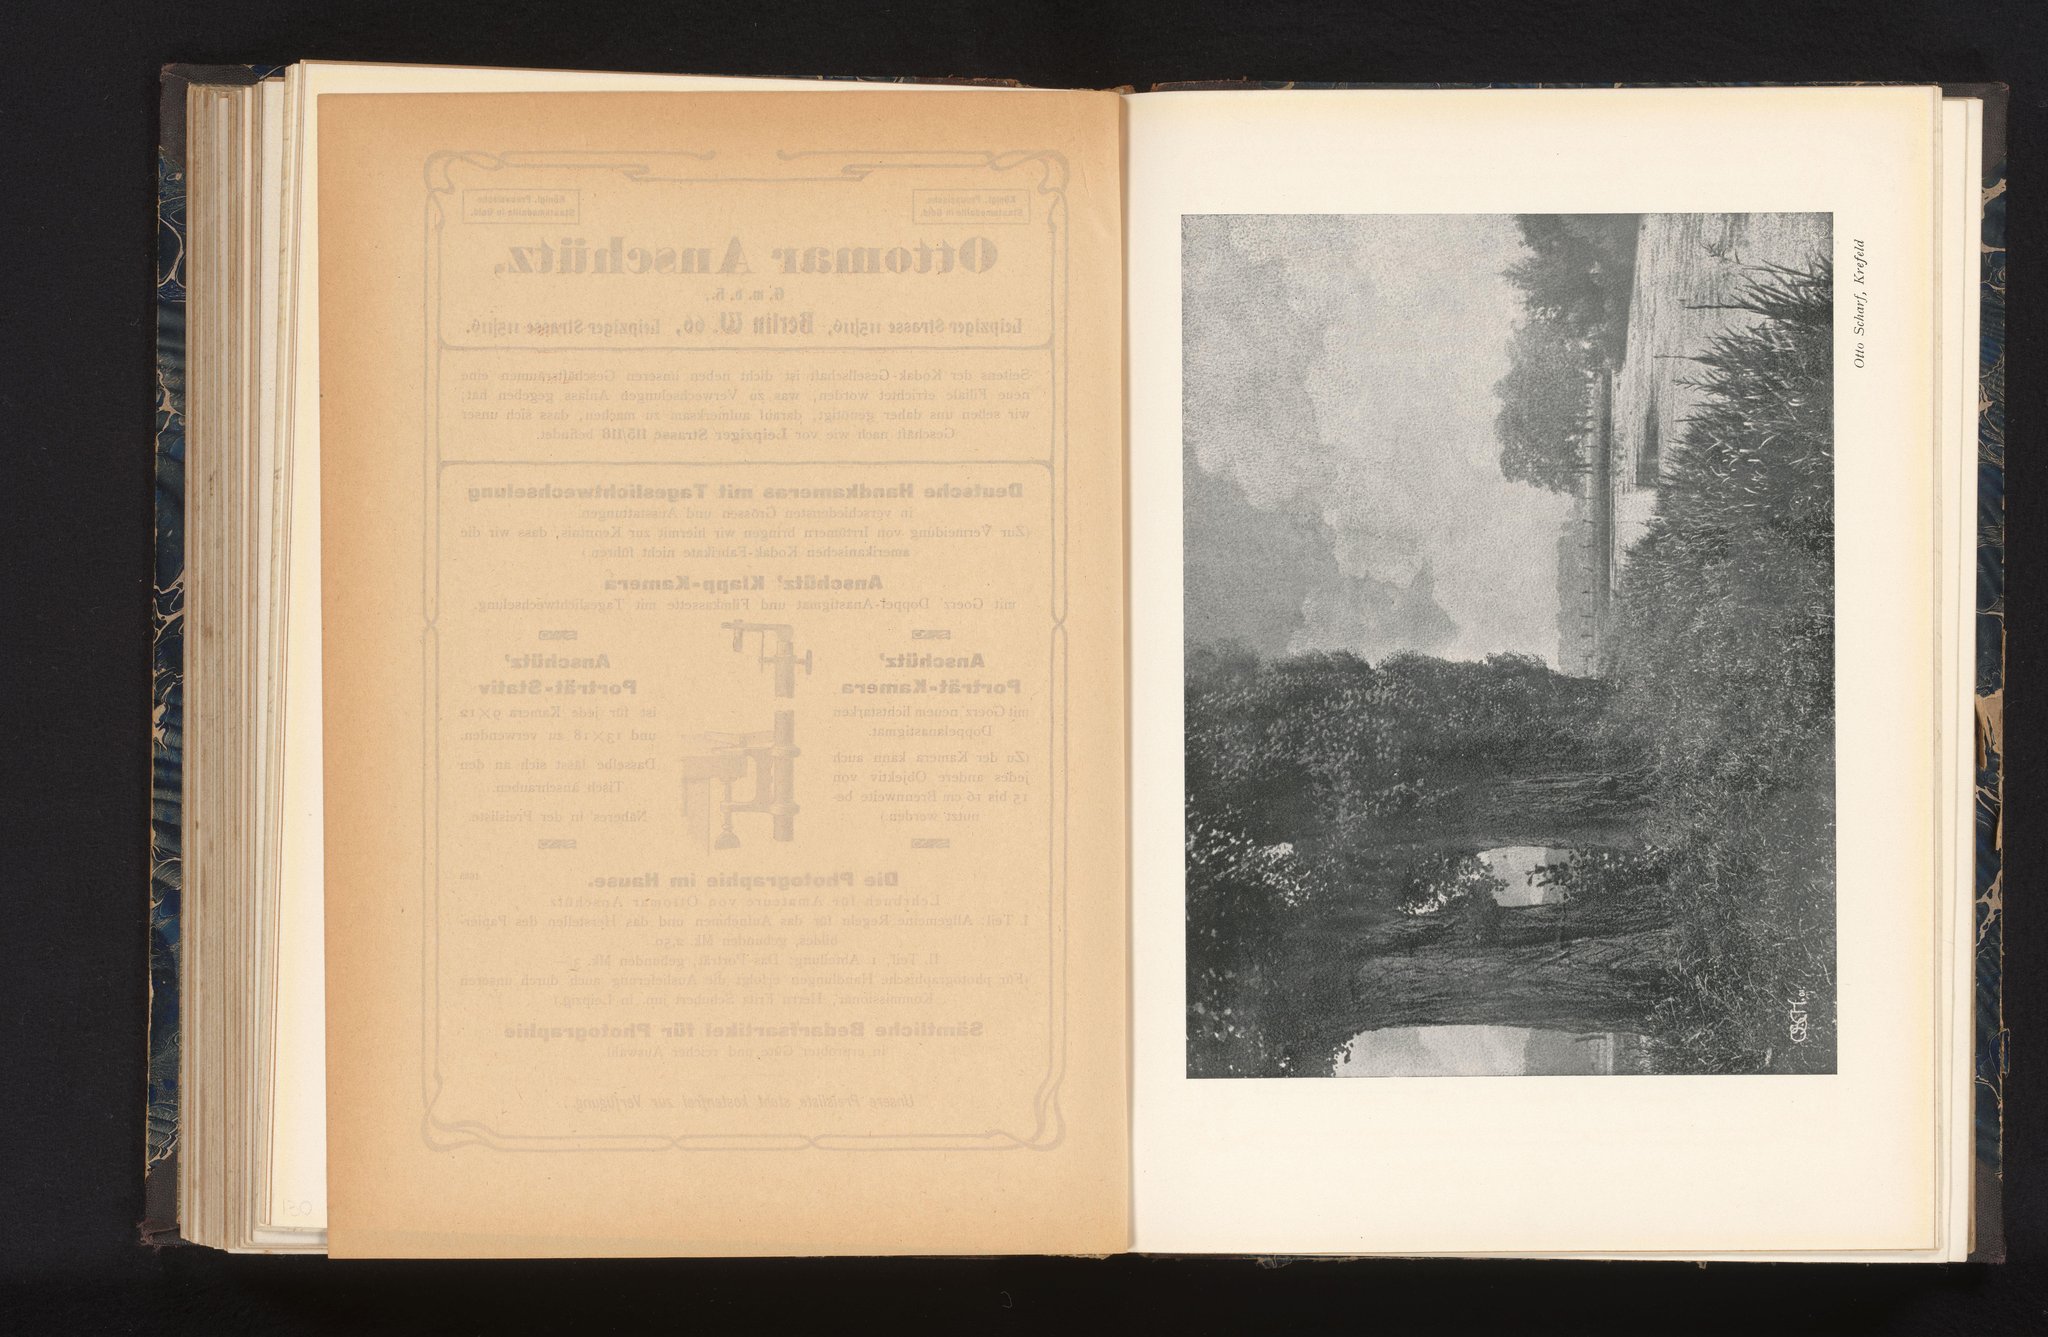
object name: photomechanical print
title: Gezicht op bomen aan het water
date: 1897-1902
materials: paper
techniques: autotype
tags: trees, small canal, ditch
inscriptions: monogram: ‘Leipzig/ S.G.’